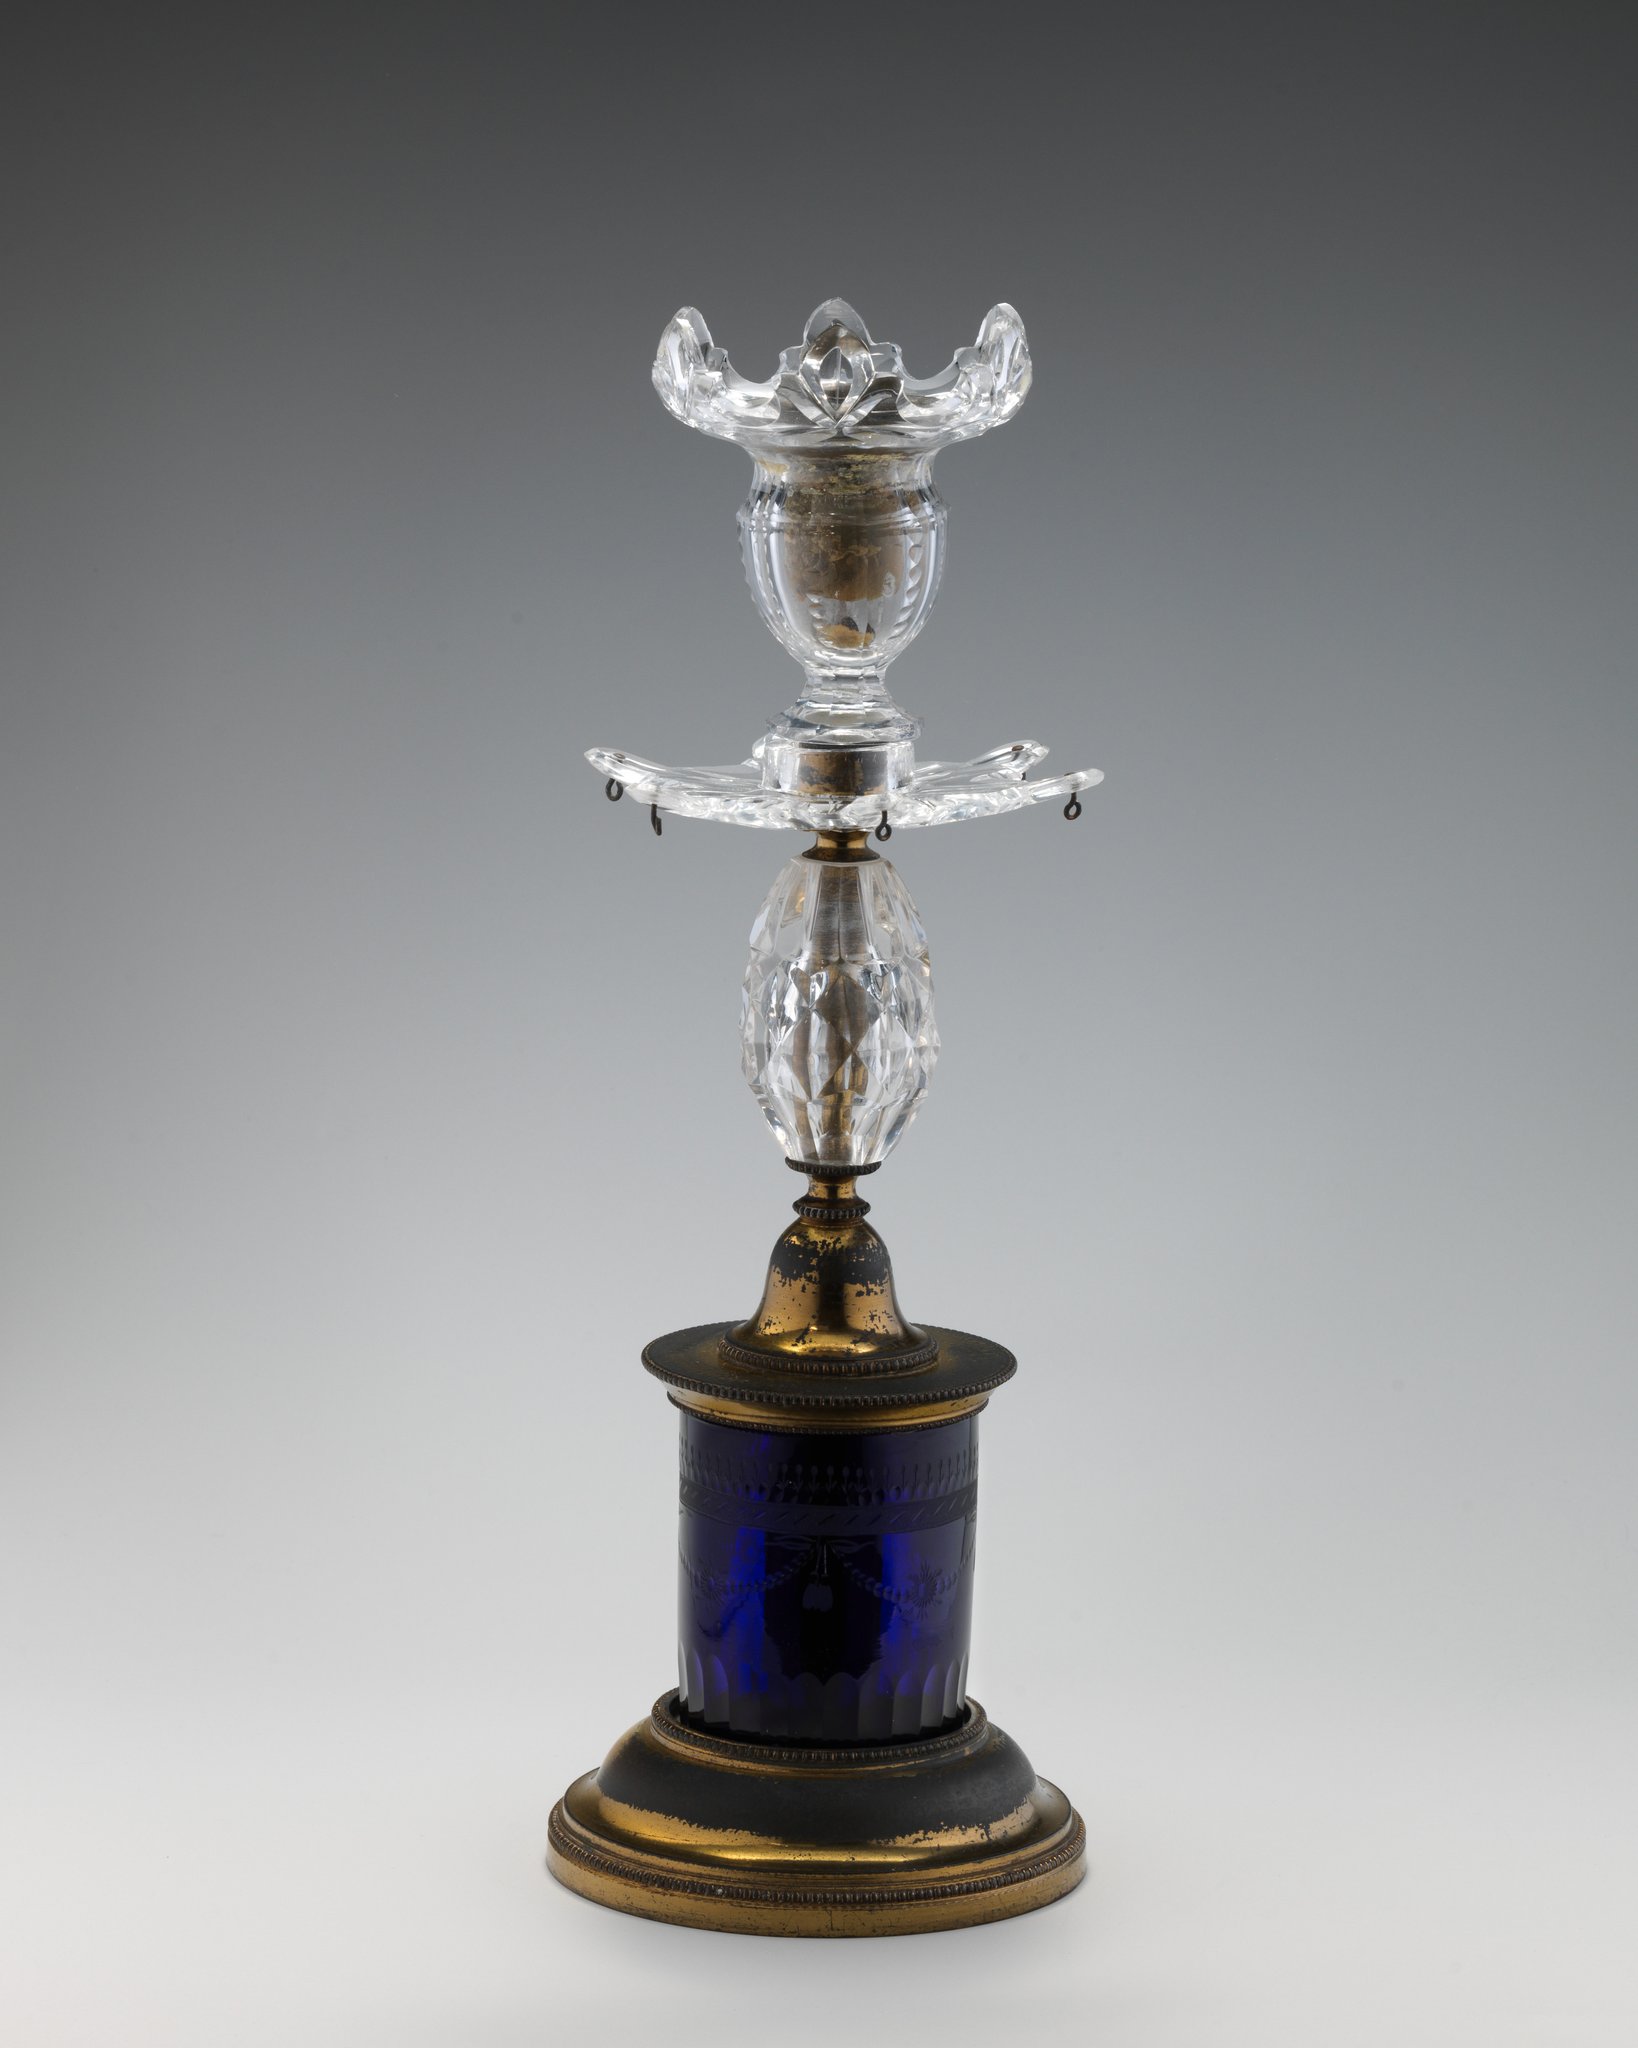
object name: candlestick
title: Candlestick (one of a pair)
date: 1780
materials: gilt bronze, glass